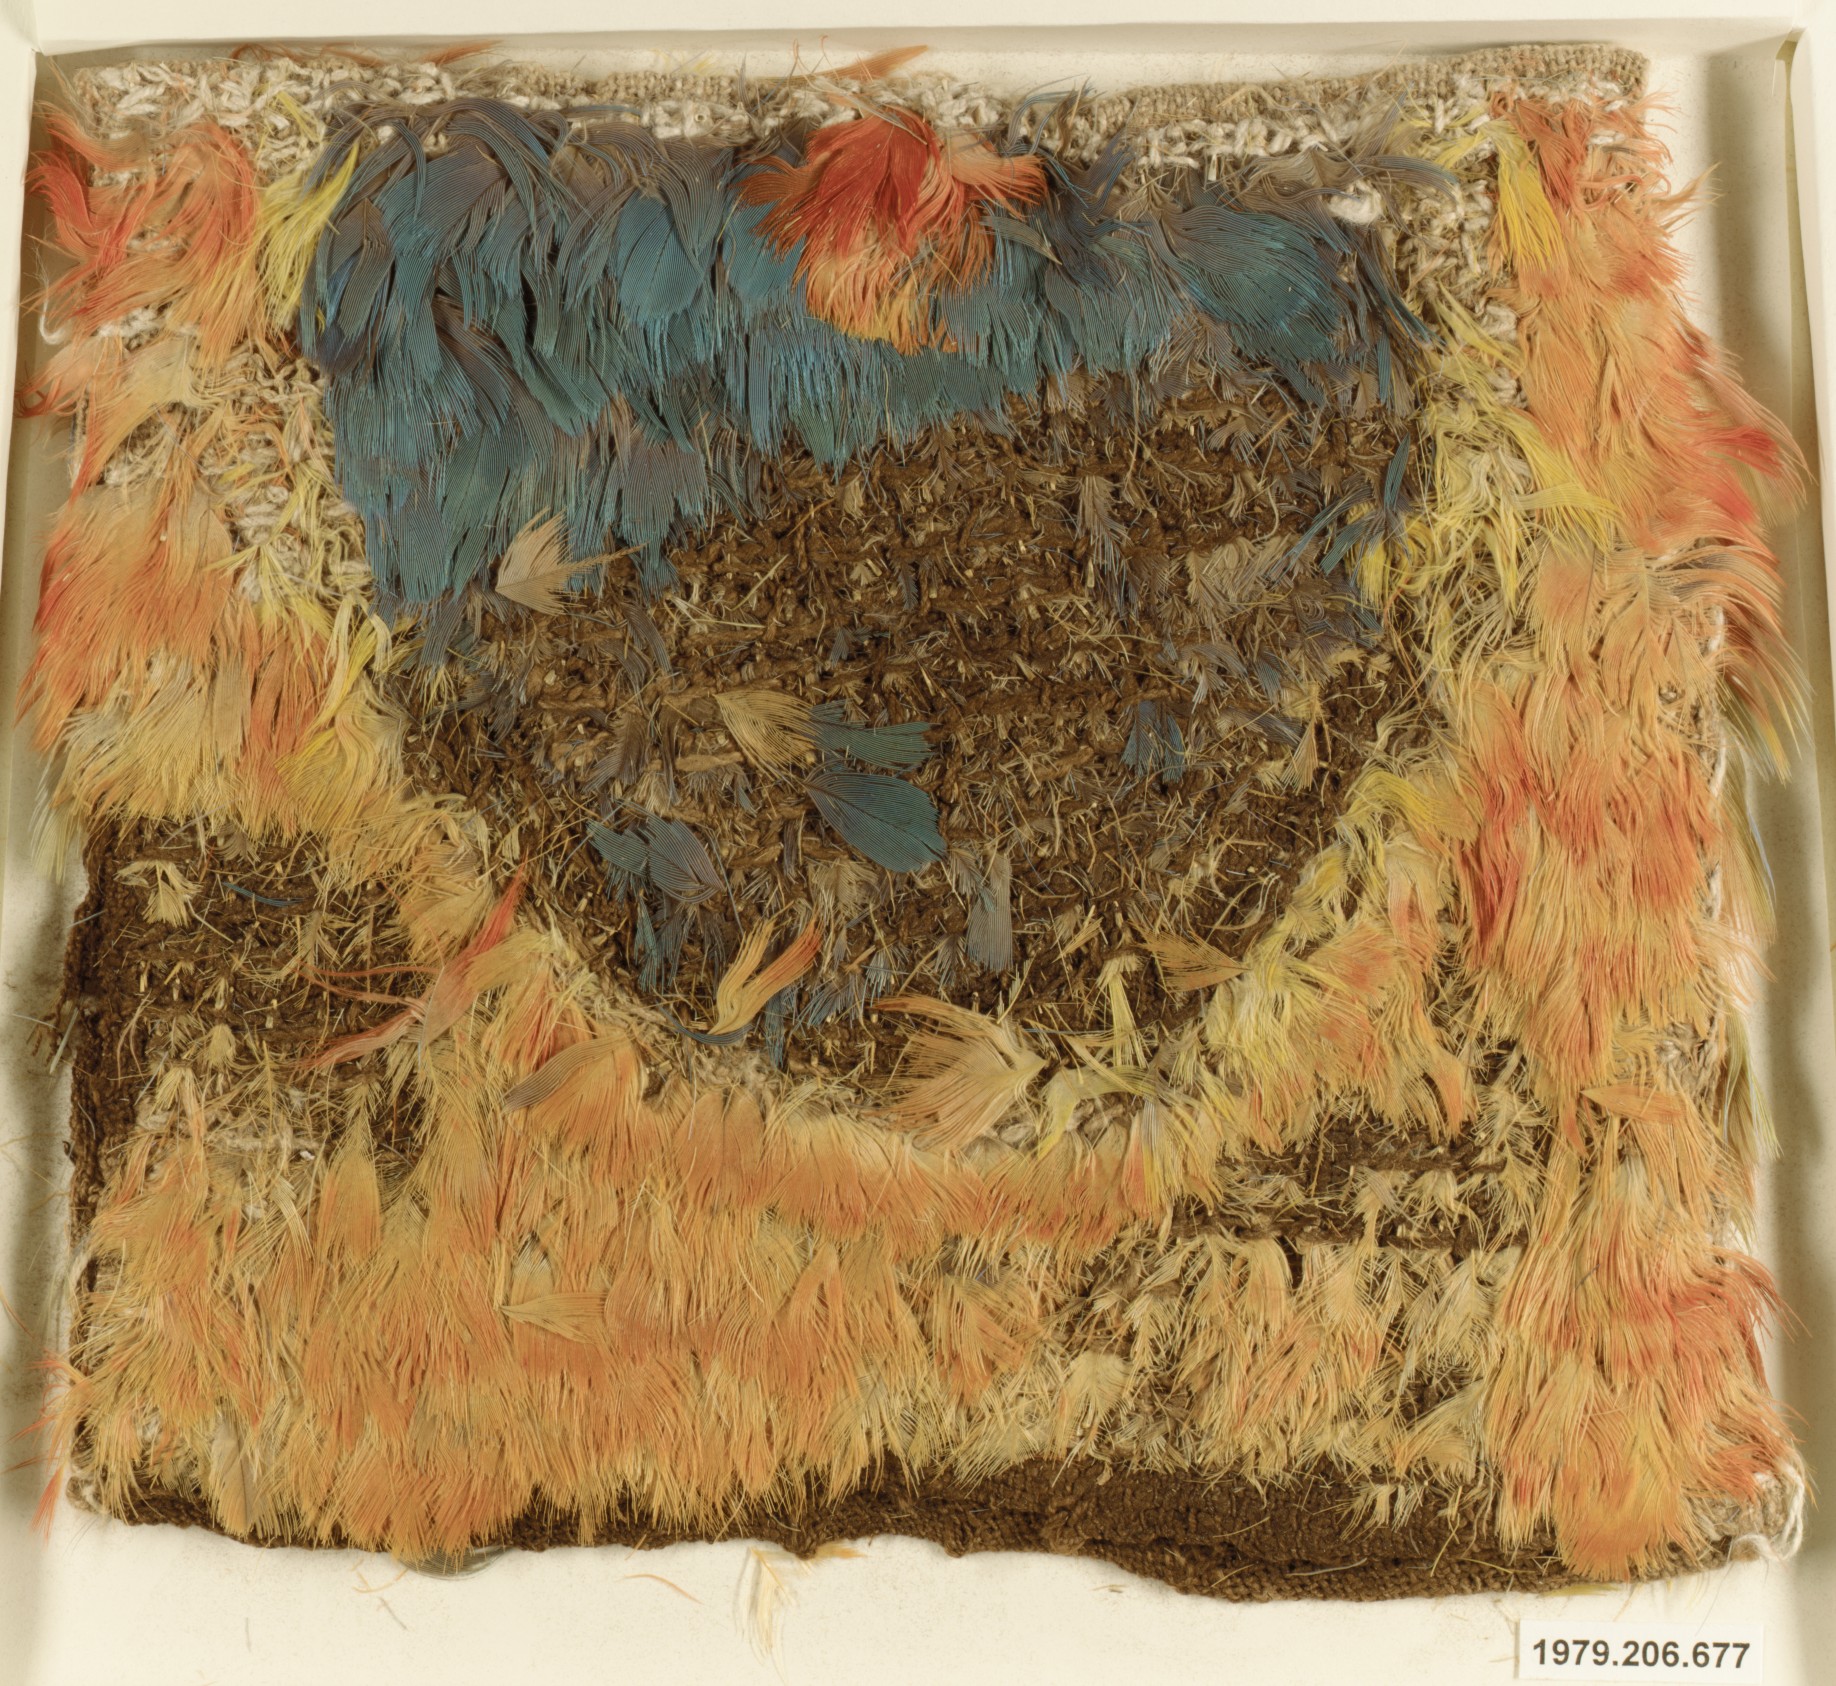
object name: miniature tunic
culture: ica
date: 1101-1300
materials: cotton, feather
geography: peru